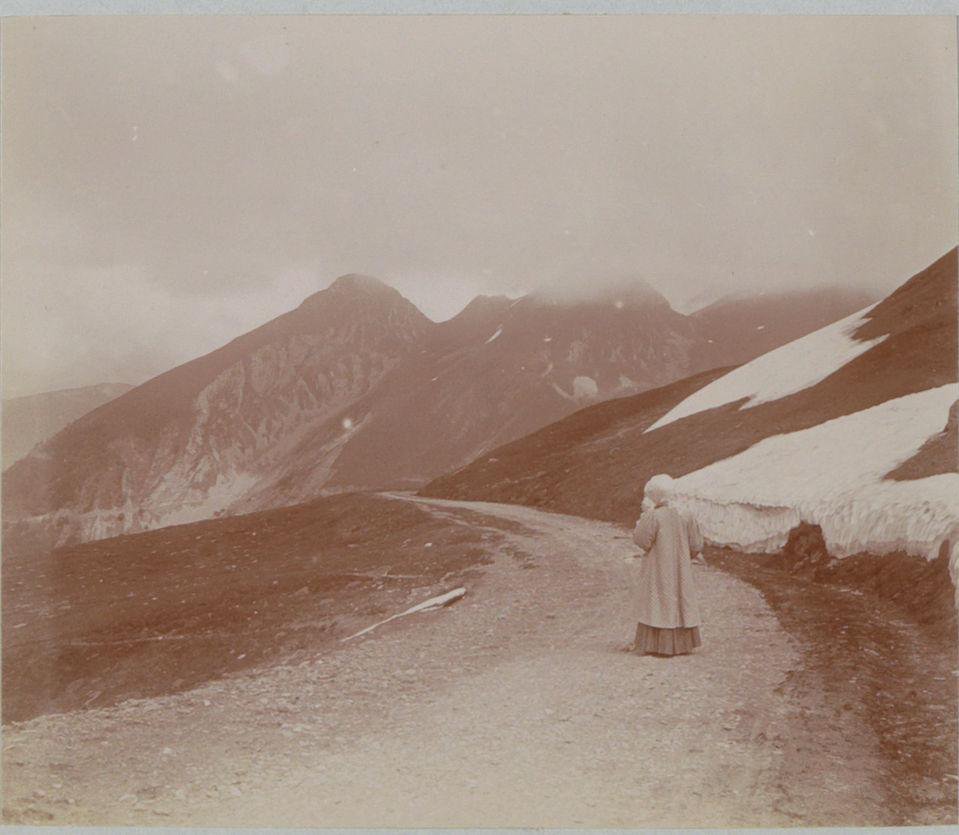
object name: photograph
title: Vrouw in een lange mantel op een besneeuwde bergpas, vermoedelijk in Frankrijk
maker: Anonymous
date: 1905-1910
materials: paper, photographic support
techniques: gelatin silver print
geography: france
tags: adult woman, road, path, mountain-range, snow peaks, france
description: Onderdeel van Fotoalbum van een Franse amateurfotograaf met bezienswaardigheden in Frankrijk, Zwitserland en Italië.